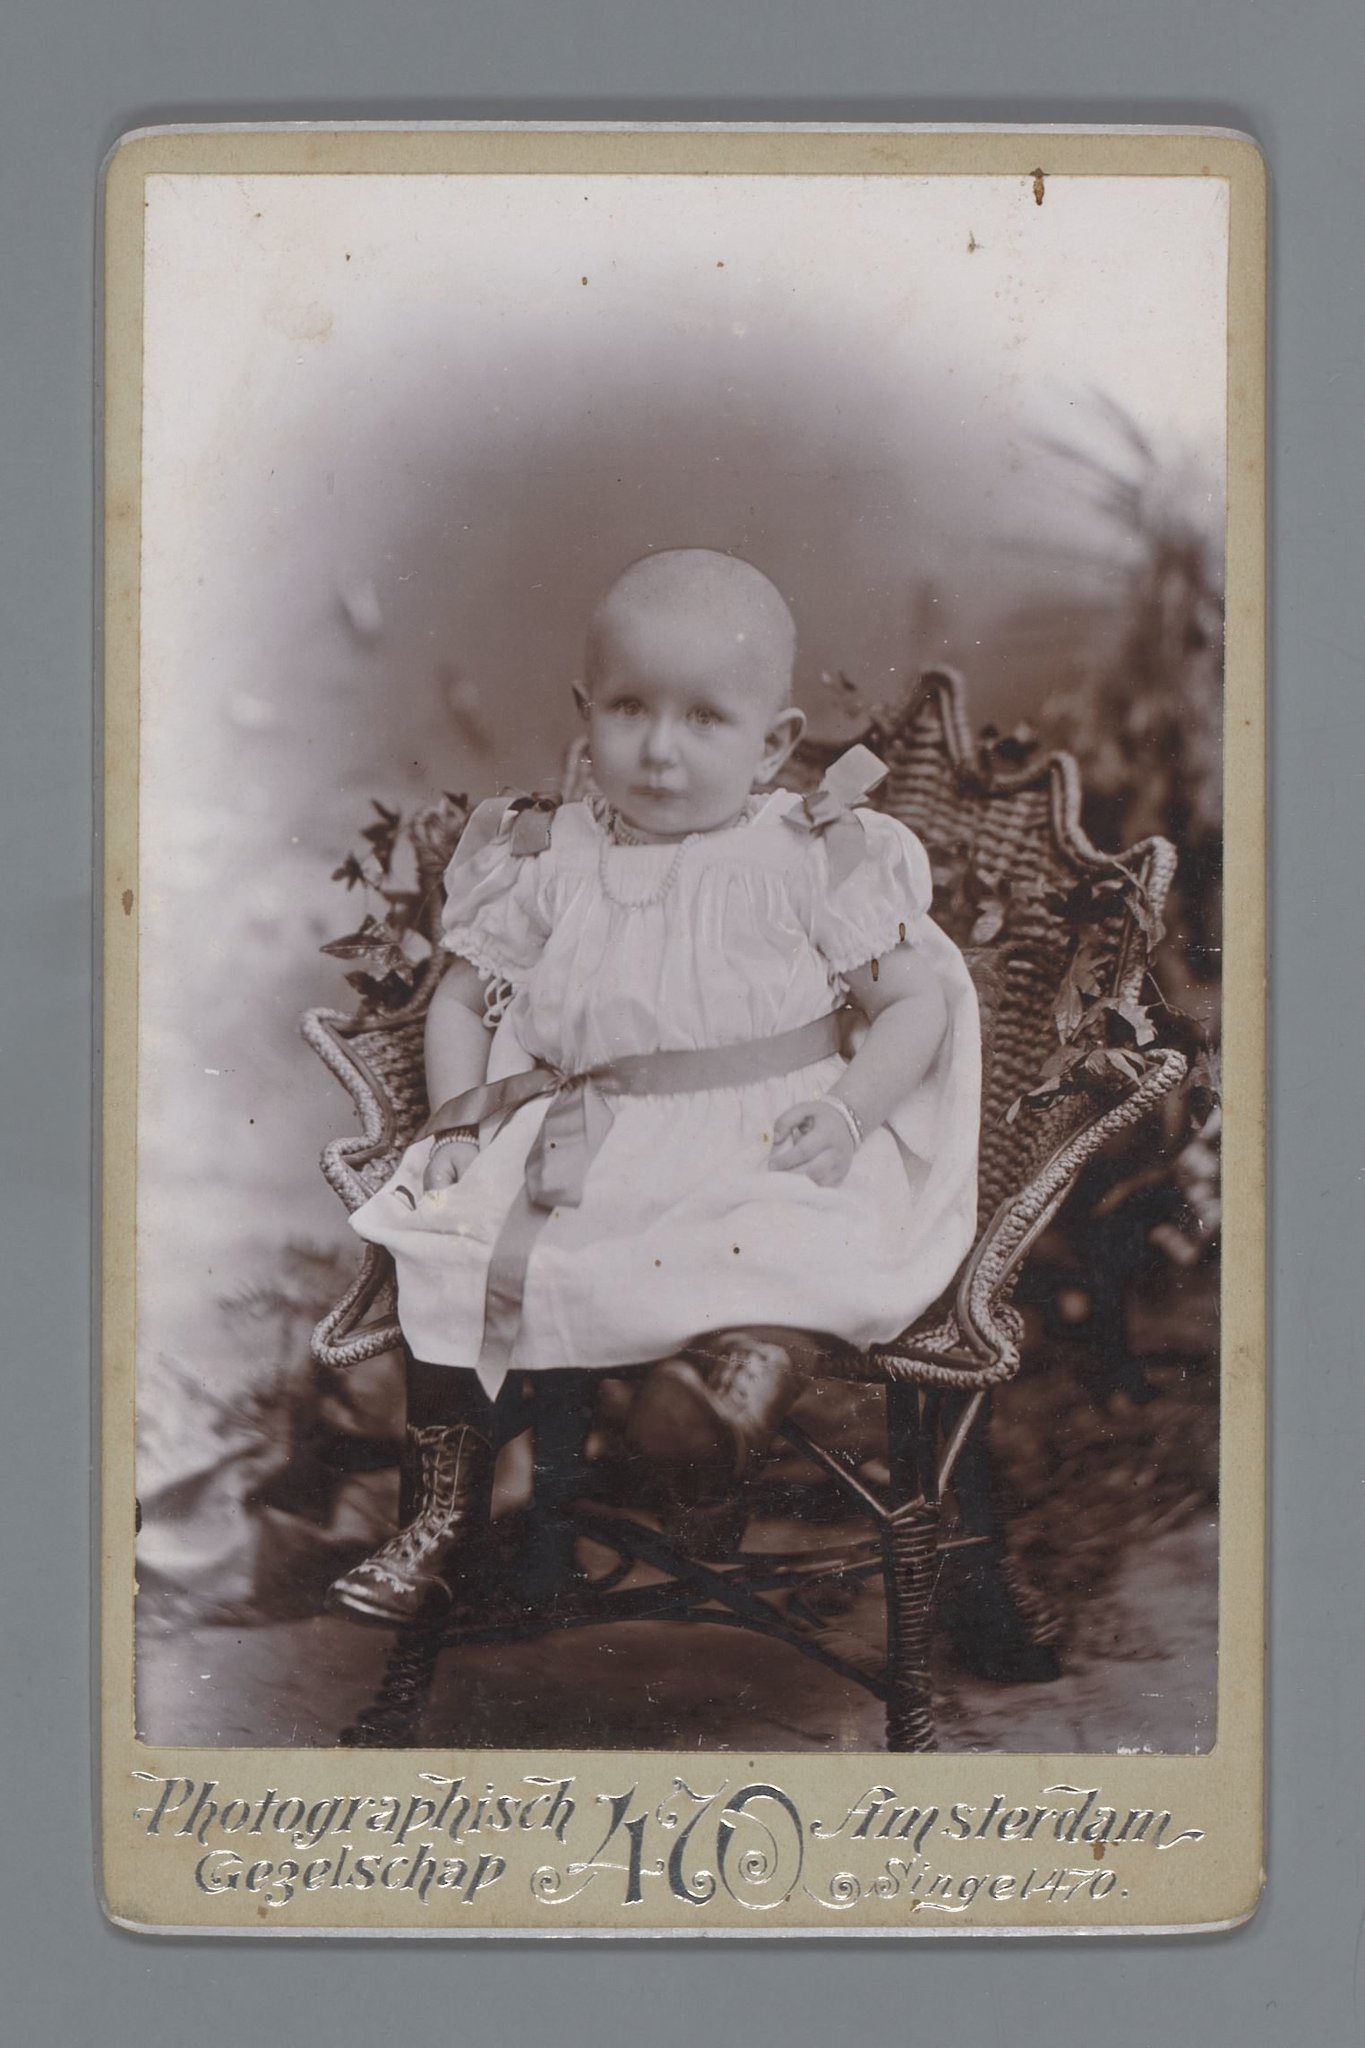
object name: cabinet photograph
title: Studioportret van een kind op een rieten stoel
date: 1880-1900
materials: cardboard, photographic support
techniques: gelatin silver print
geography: amsterdam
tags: infant, baby, chair